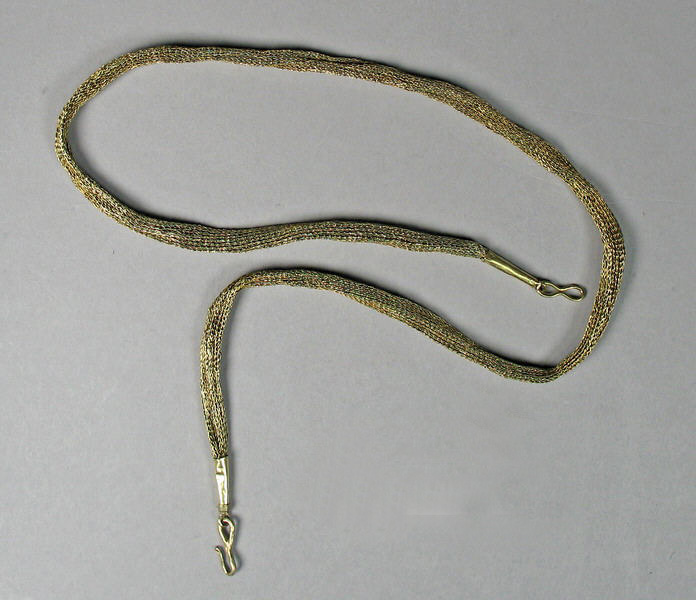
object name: chain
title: Chain, Loop-in-Loop, Trumpet Ends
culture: indonesian, central java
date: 701-1200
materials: gold